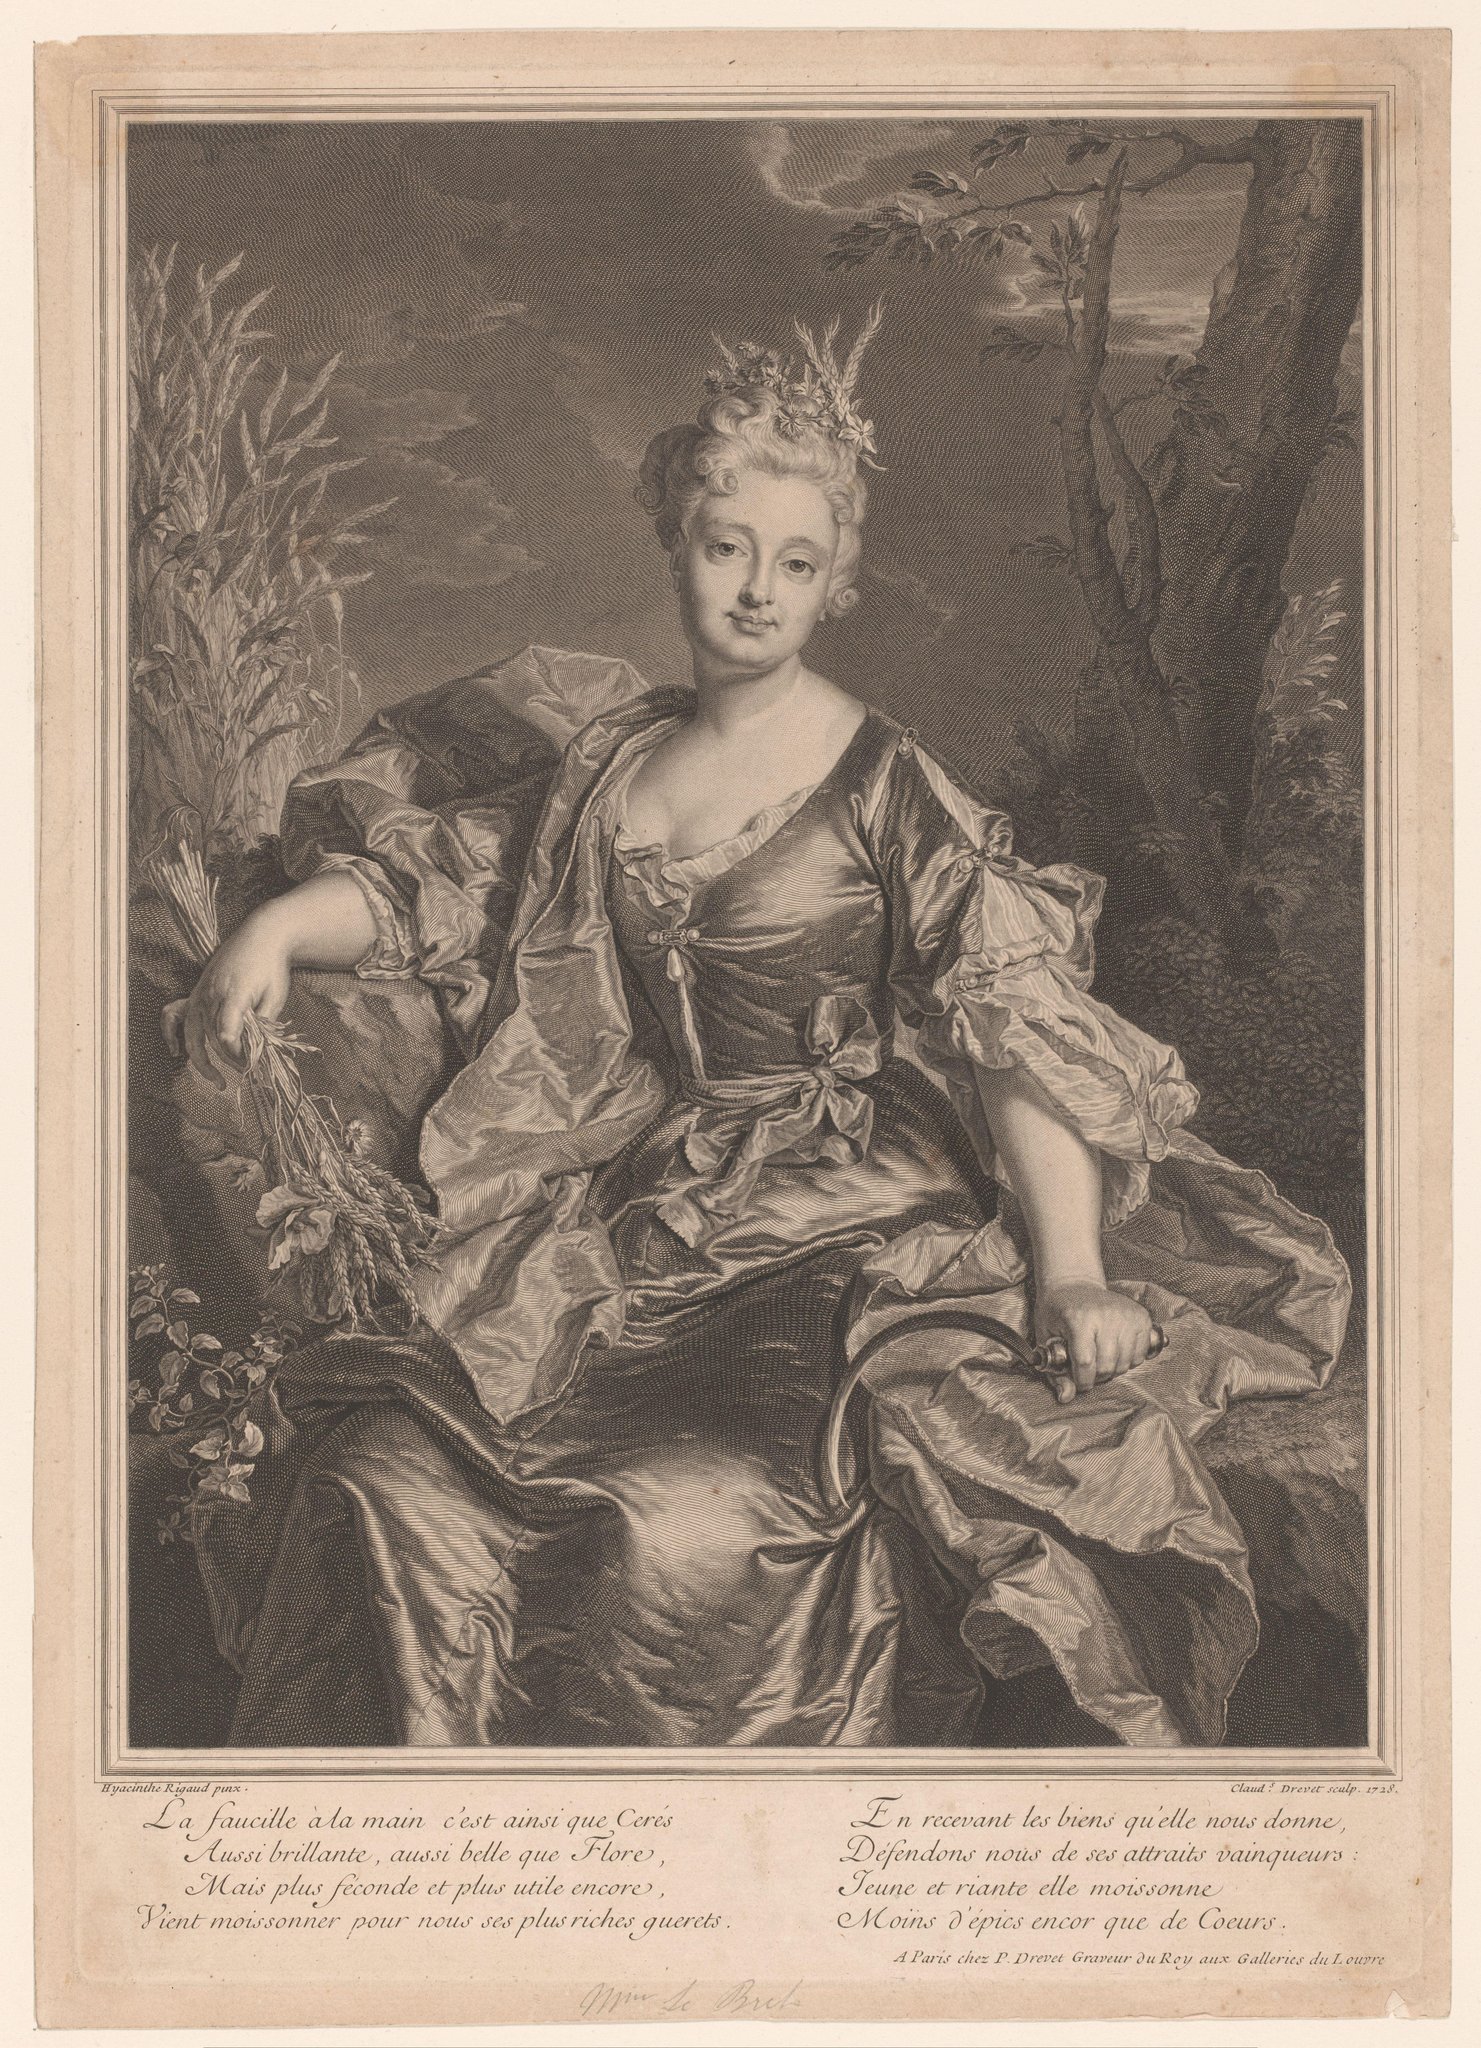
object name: print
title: Portret van Marguerite Henriette de La Briffe Le Bret als Ceres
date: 1728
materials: paper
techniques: engraving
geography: paris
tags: (story of) ceres (demeter), historical persons - bb - woman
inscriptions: collector's mark: Lugt 2228